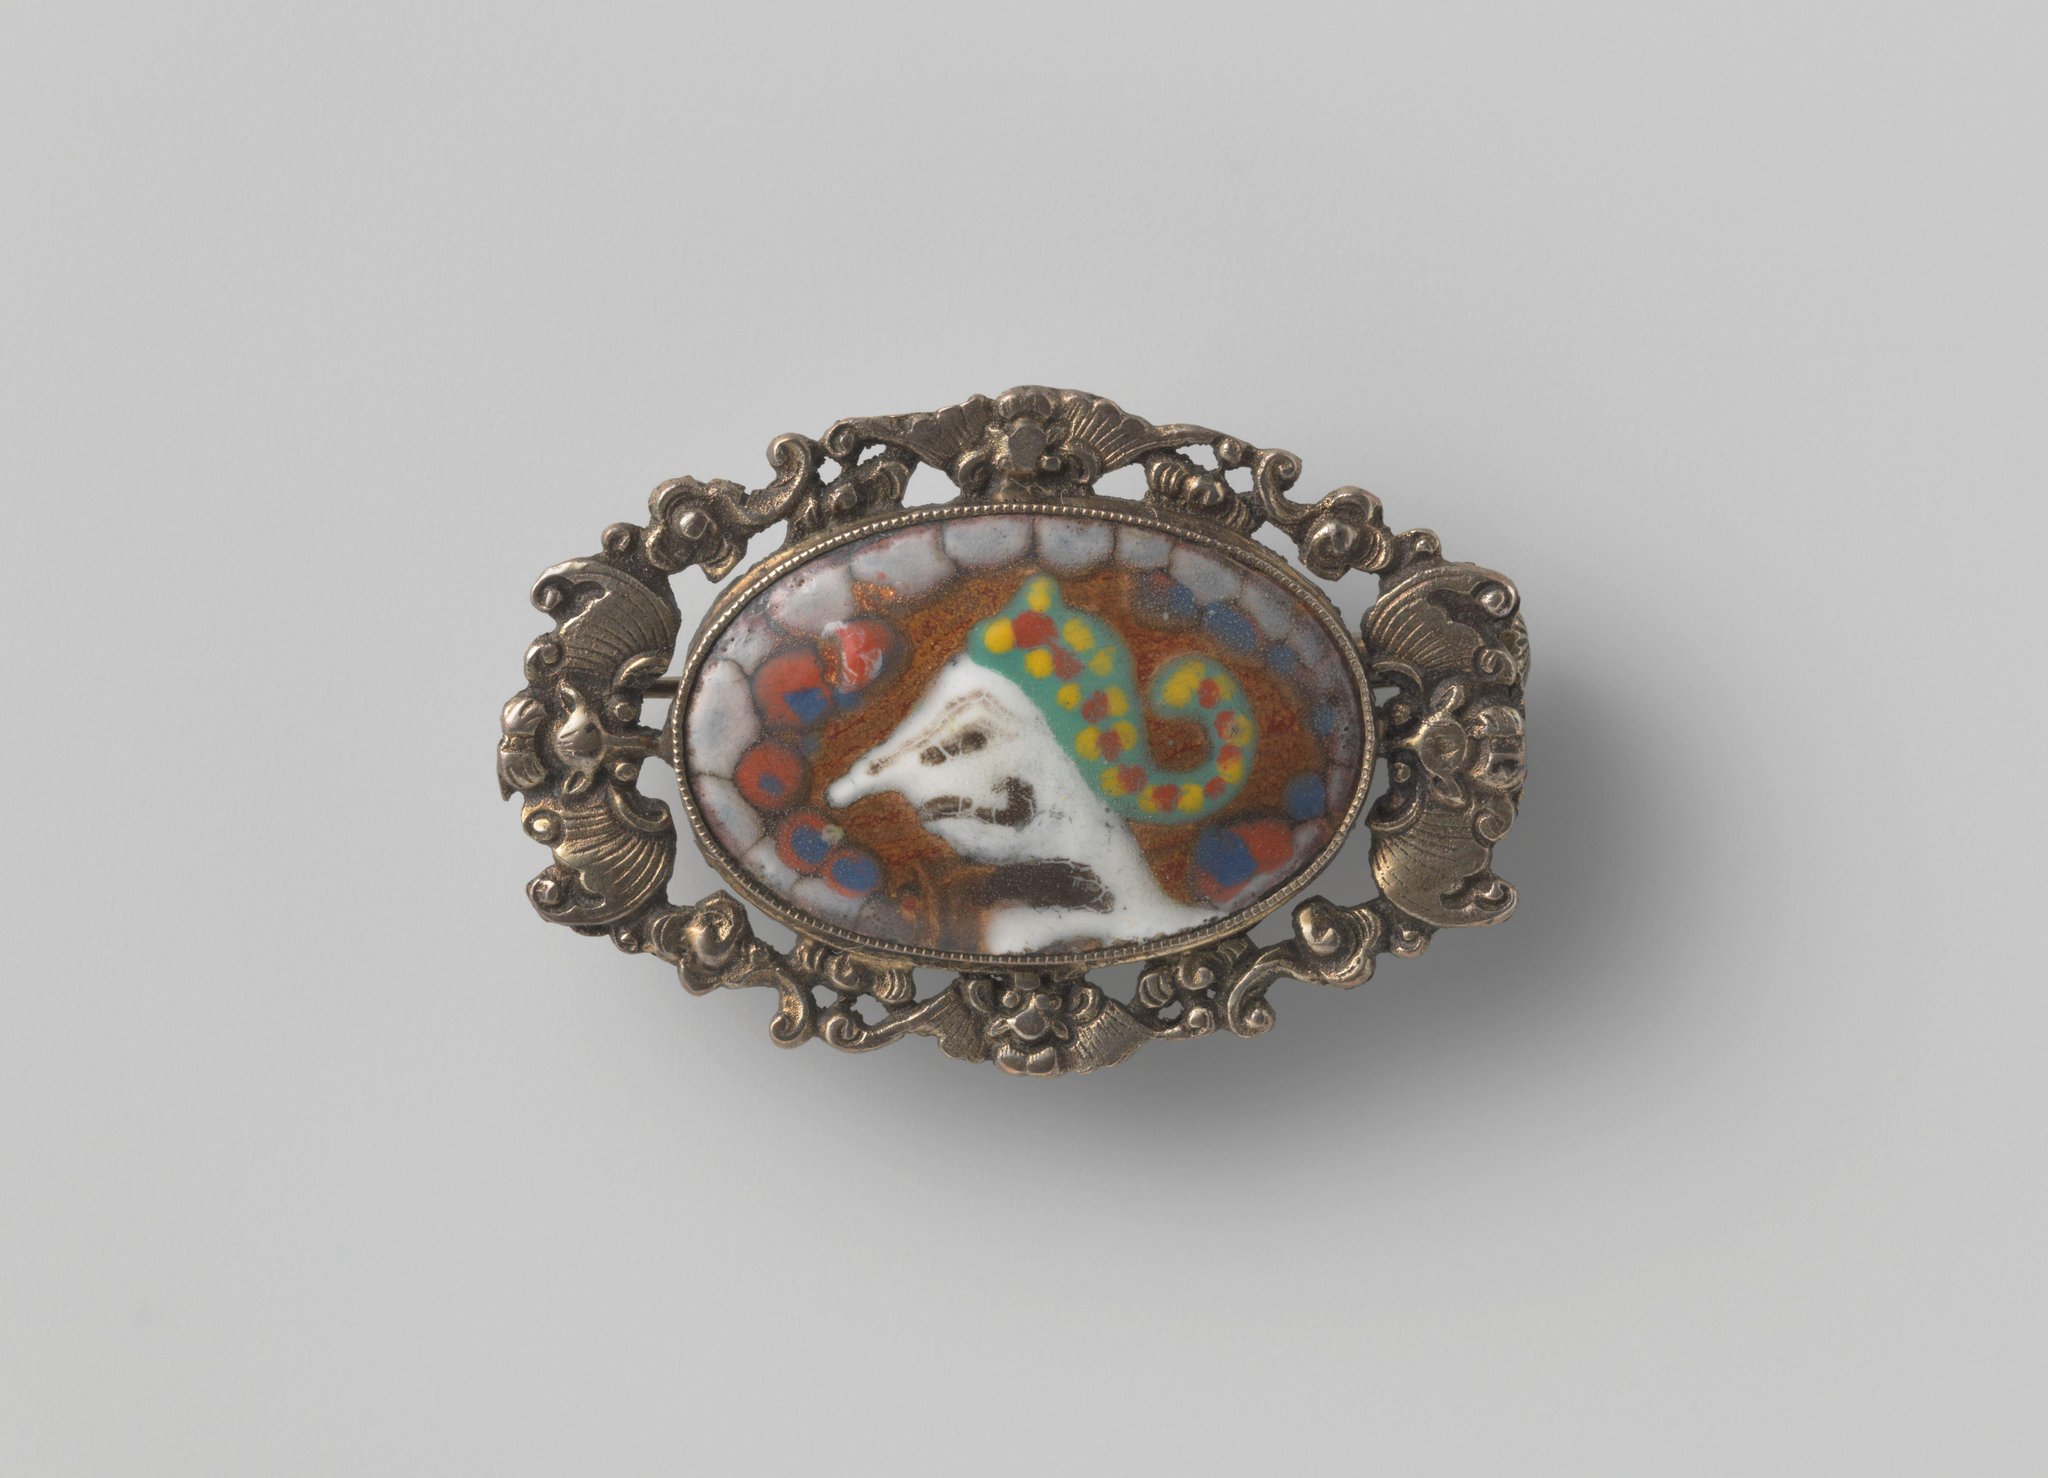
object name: brooch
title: Broche met wajangpop in email in zilveren rand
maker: s. fuchs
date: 1937-1971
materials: copper, silver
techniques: enameling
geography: amsterdam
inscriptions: maker's mark: ‘2SF’, : ‘I’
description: Broche met wajangpop in ovaalvormig email op koper in zilveren rand voorzien van een kanonsluiting.